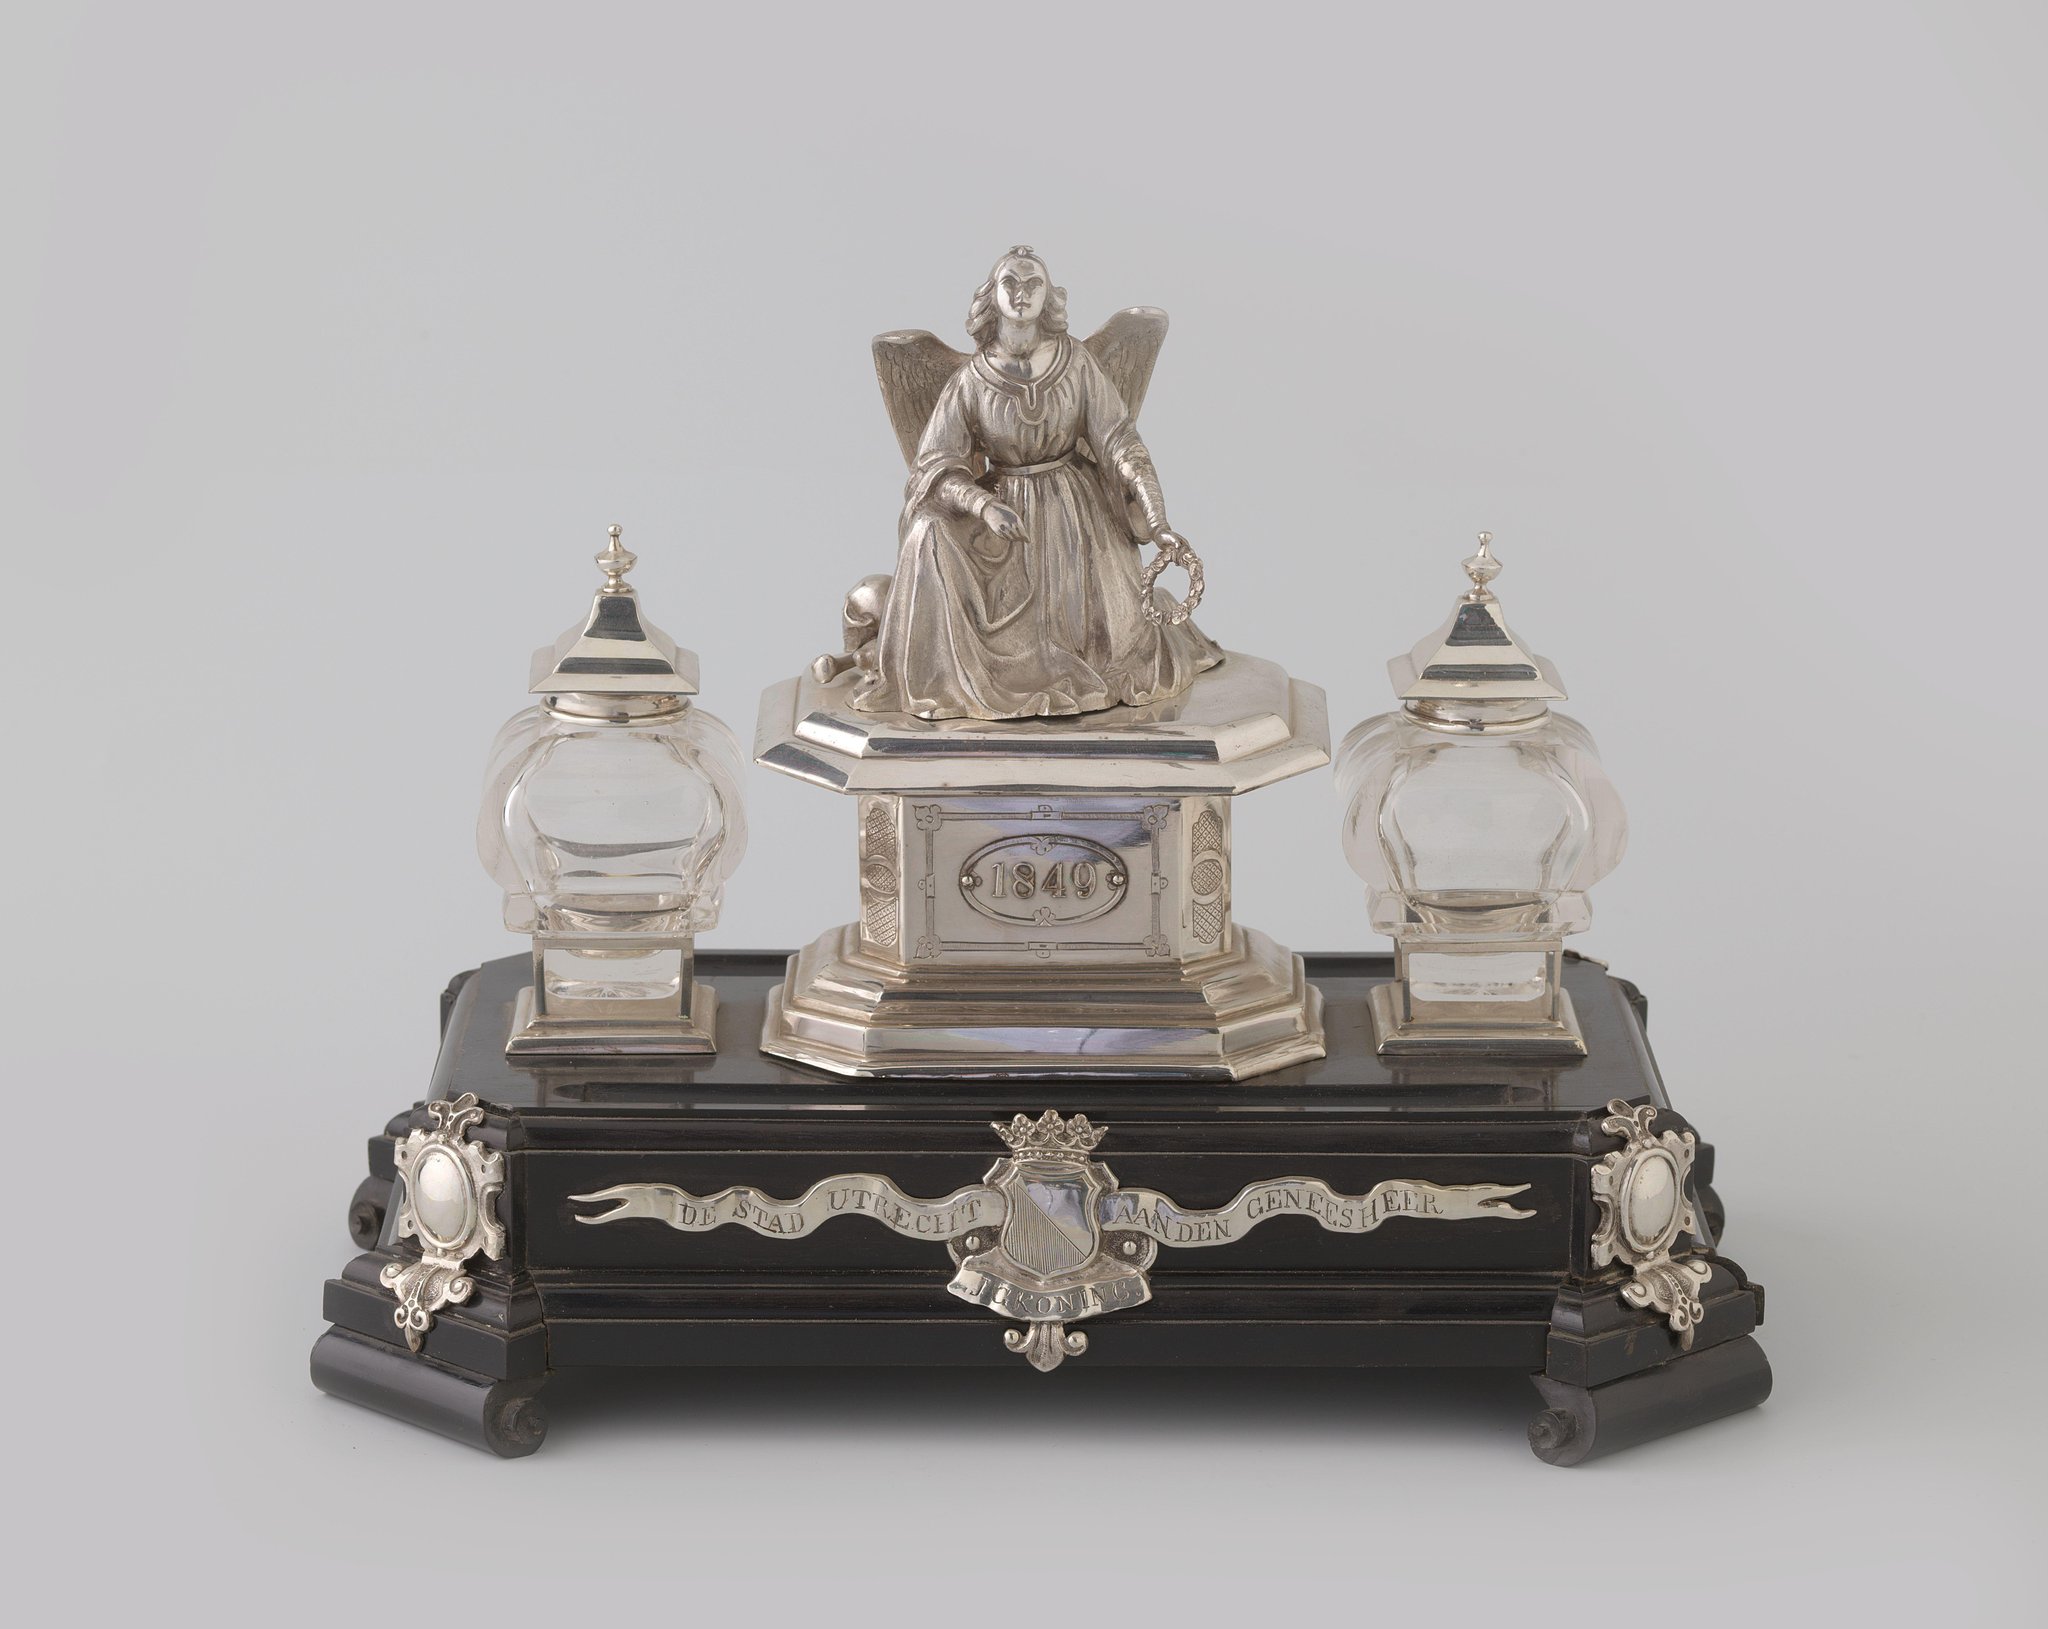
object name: sander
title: Inktpot of zandstrooier van kristal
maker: johannes mattheus van kempen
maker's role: silversmith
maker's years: 1814-1877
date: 1850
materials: crystal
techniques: manufacturing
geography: utrecht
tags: utrecht